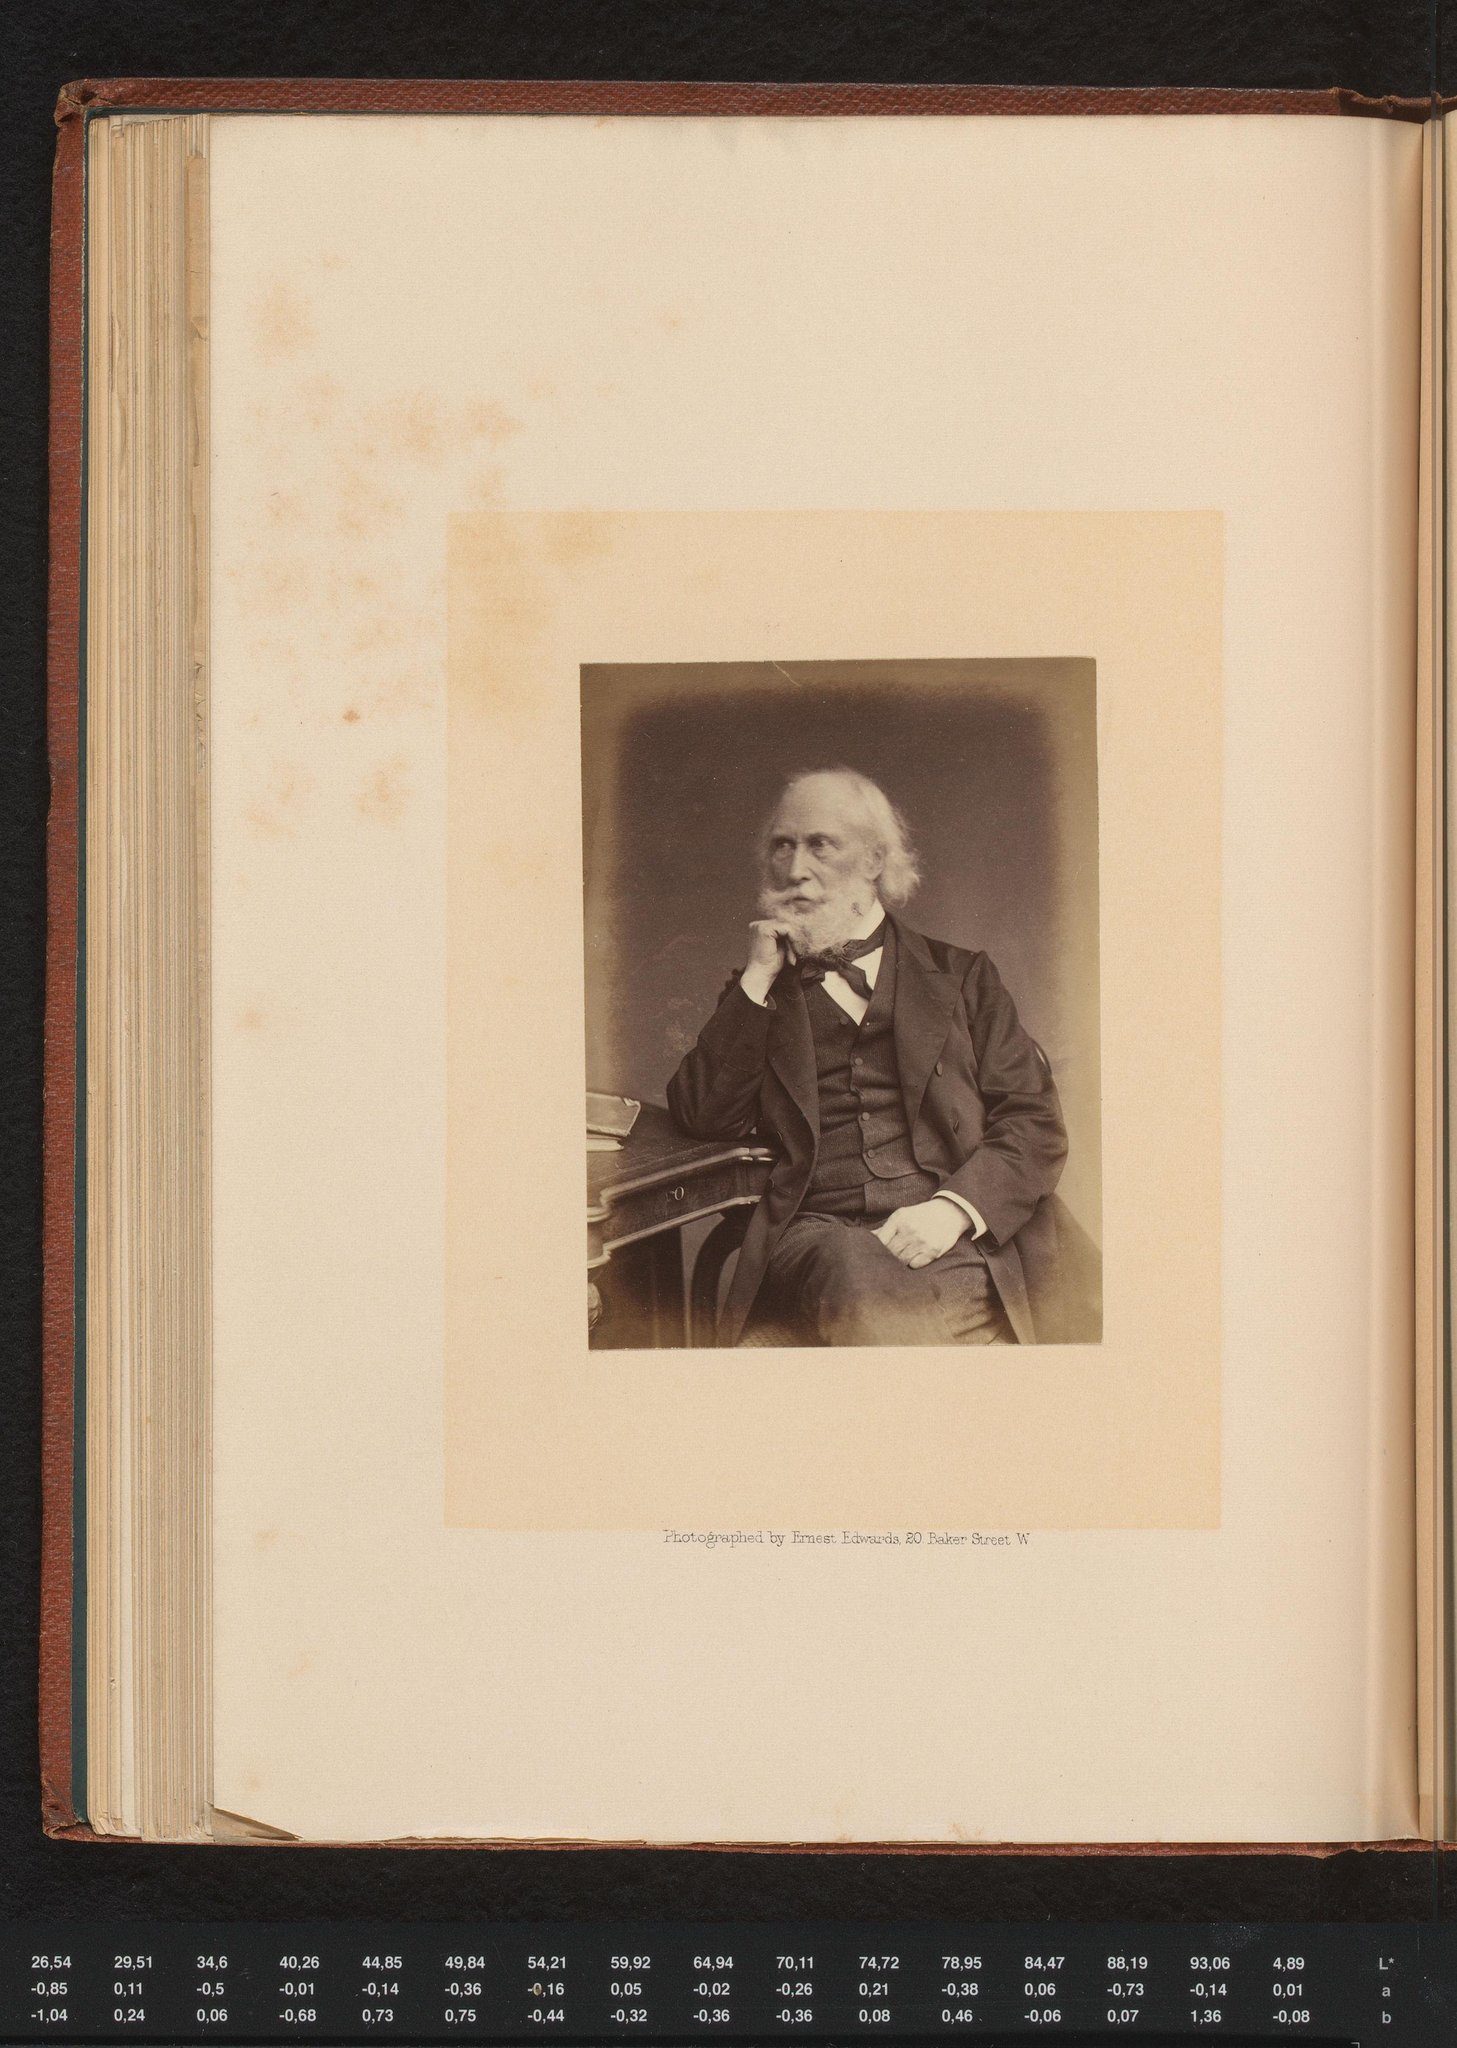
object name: page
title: Portret van de journalist en reiziger James Augustus Saint John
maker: ernest edwards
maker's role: fotograaf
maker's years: 1837-1903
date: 1862-1867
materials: paper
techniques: albumen print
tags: portrait of a writer